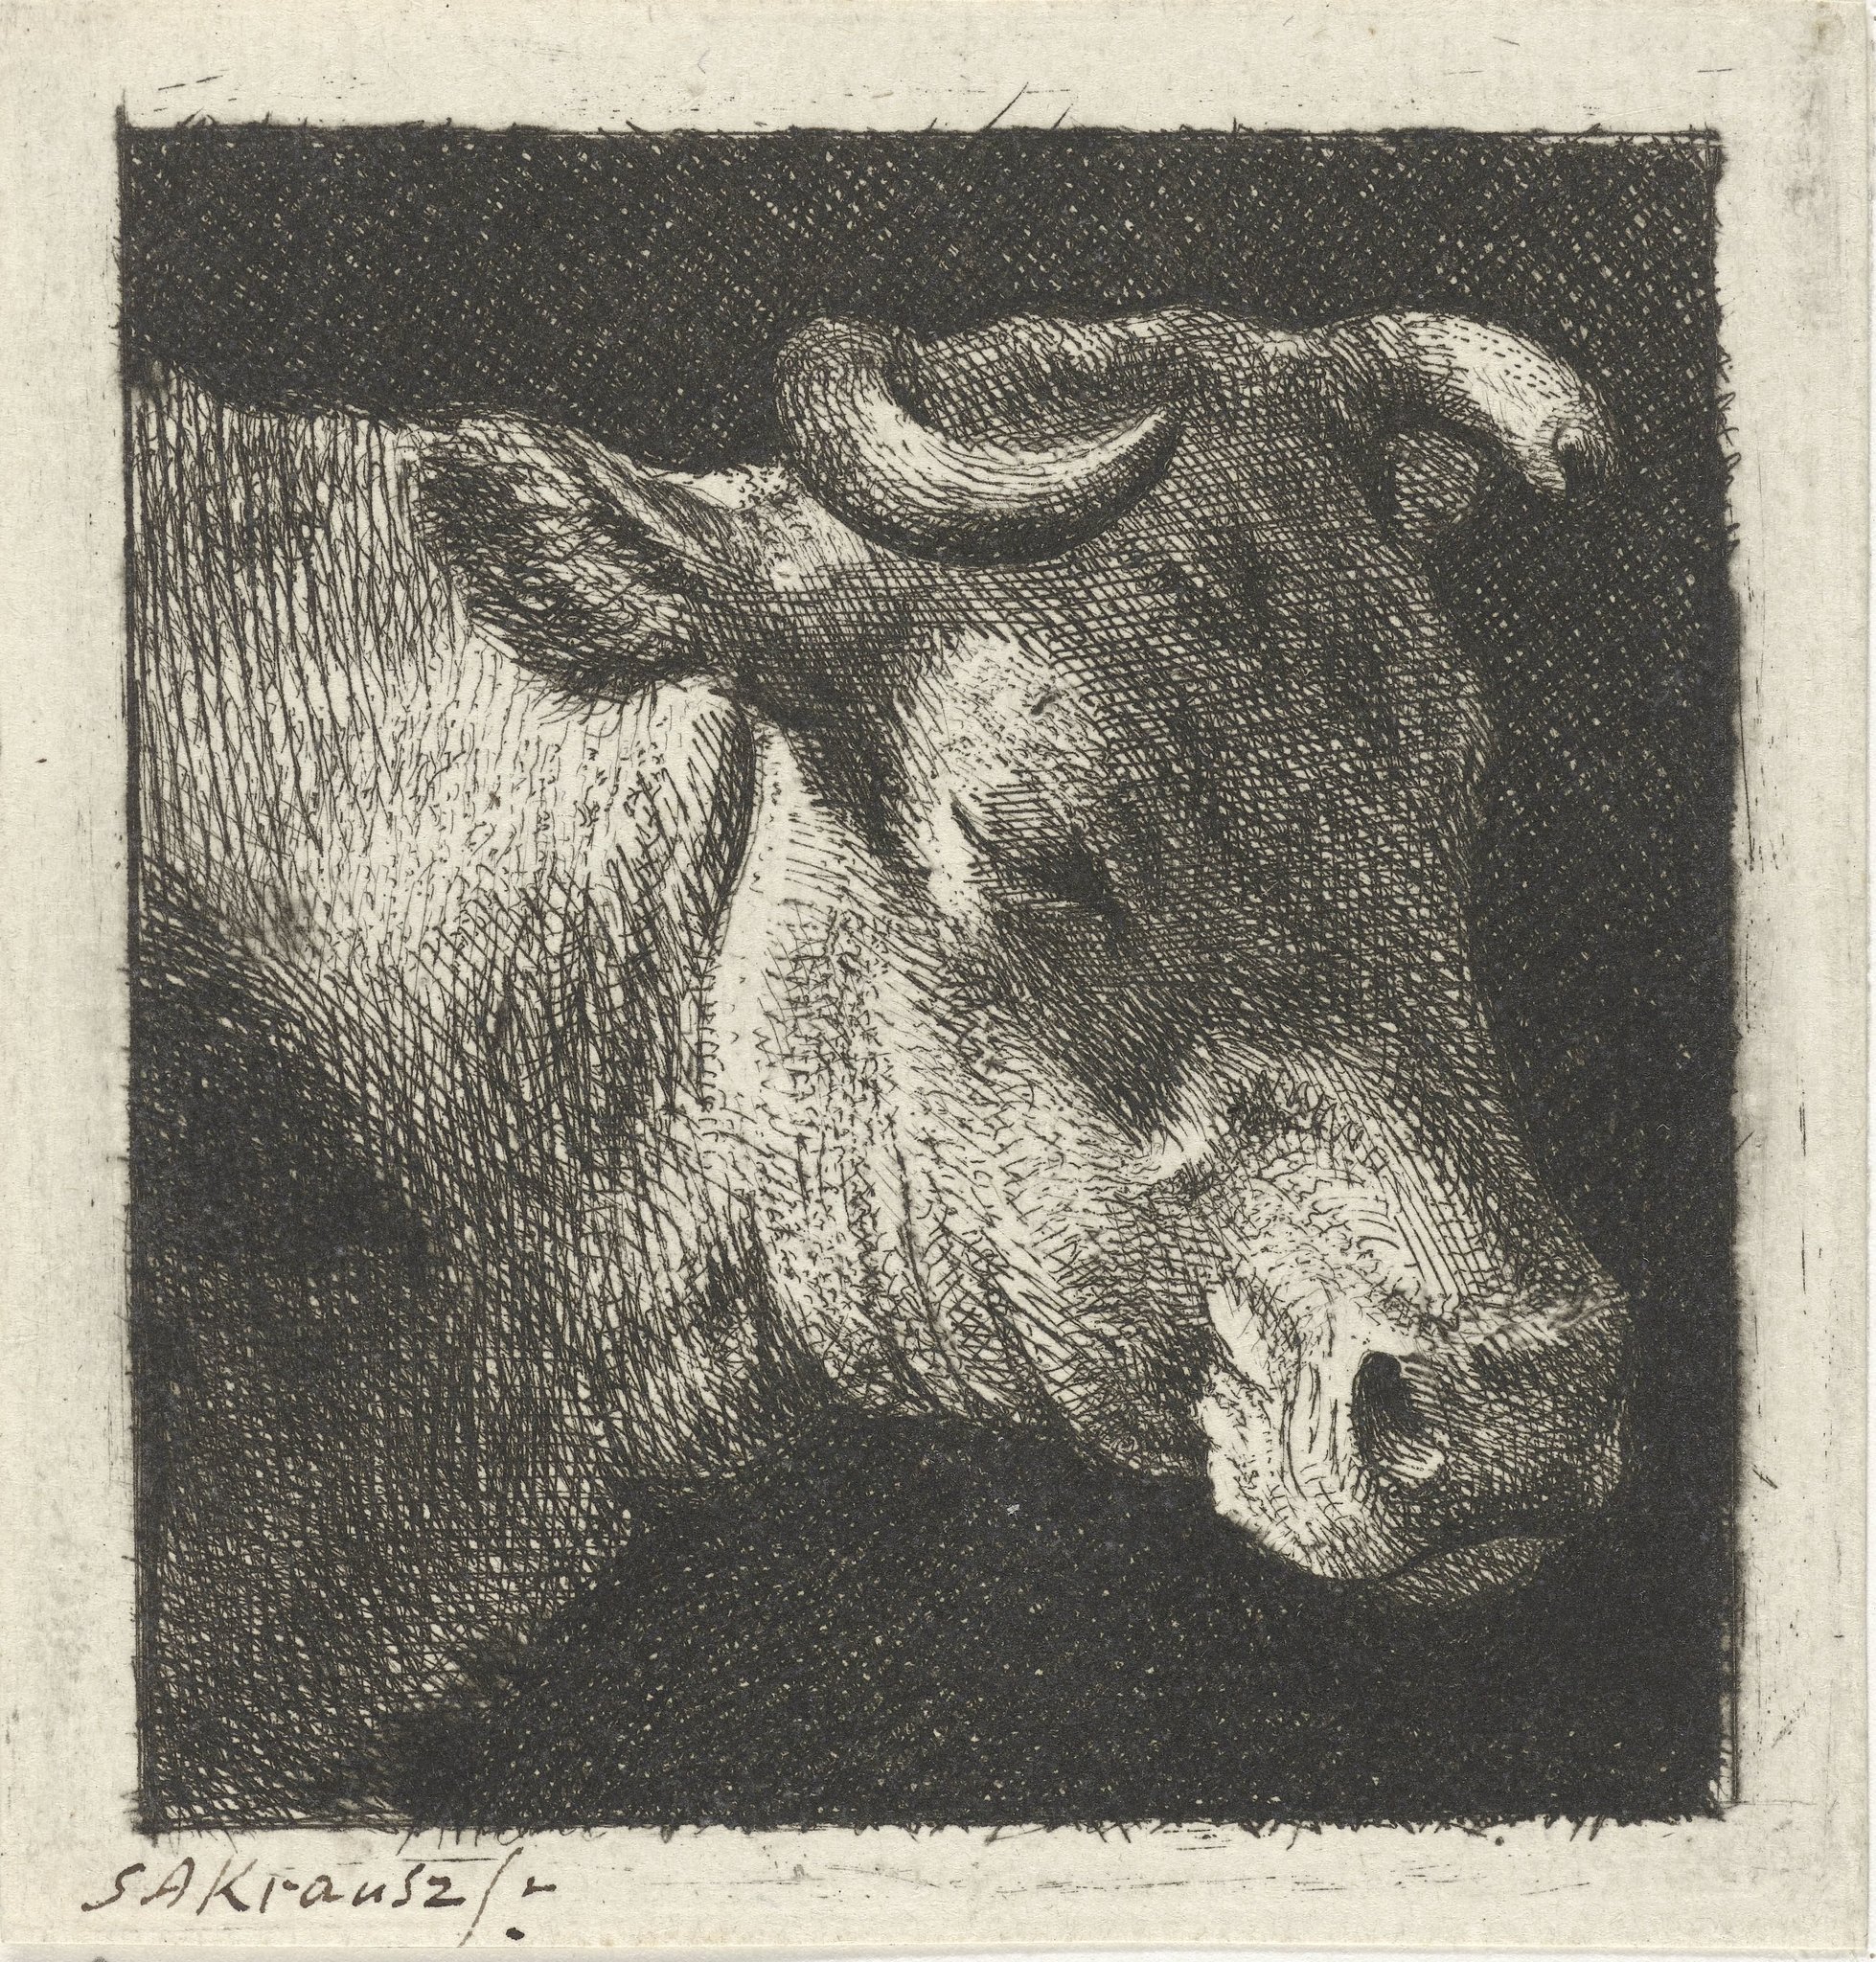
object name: print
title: Koeienkop naar rechts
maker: simon andreas krausz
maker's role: draughtsman, print maker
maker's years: 1760-1825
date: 1770-1825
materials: paper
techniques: etching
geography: the hague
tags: cow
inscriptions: inscription: ‘S A Krausz fc’, collector's mark: Lugt 2228